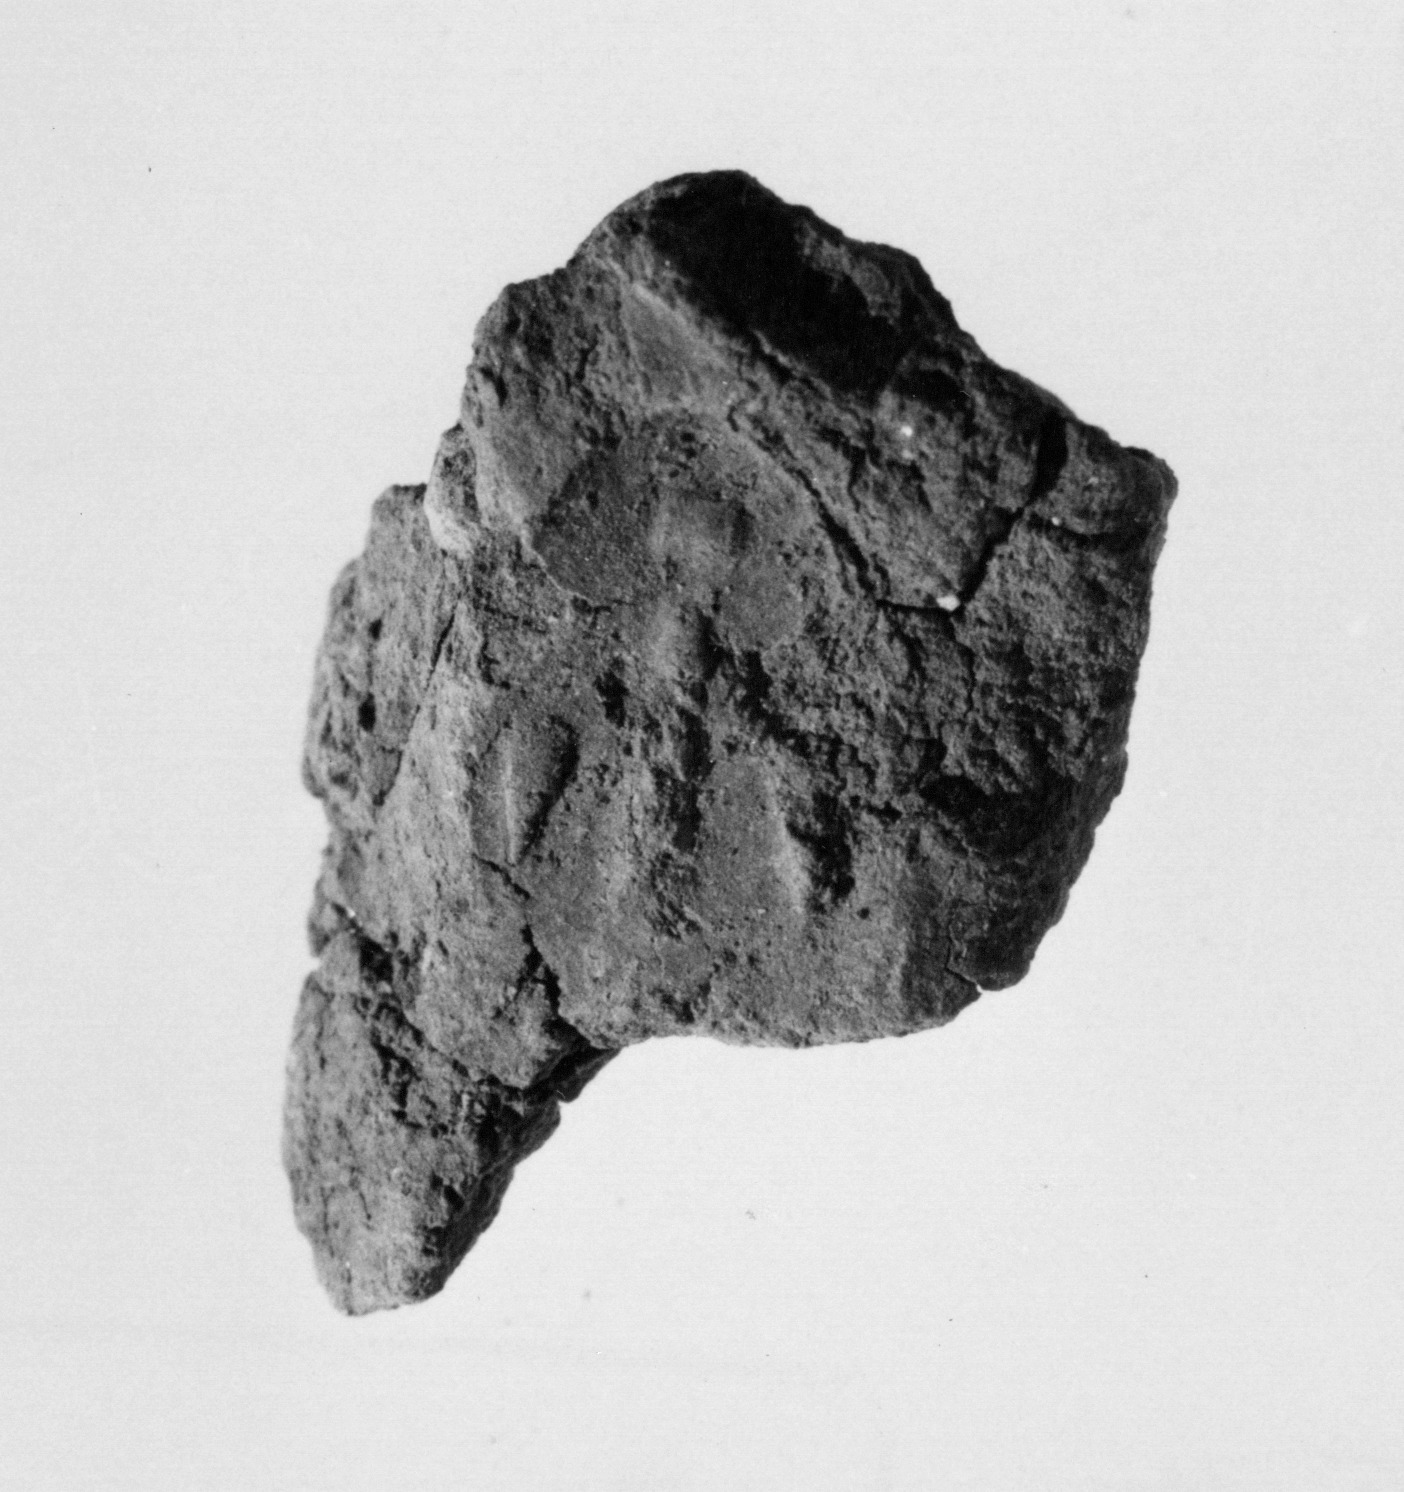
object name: sealing, djed, cobra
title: Document Sealing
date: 1390-1352 BCE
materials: mud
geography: egypt